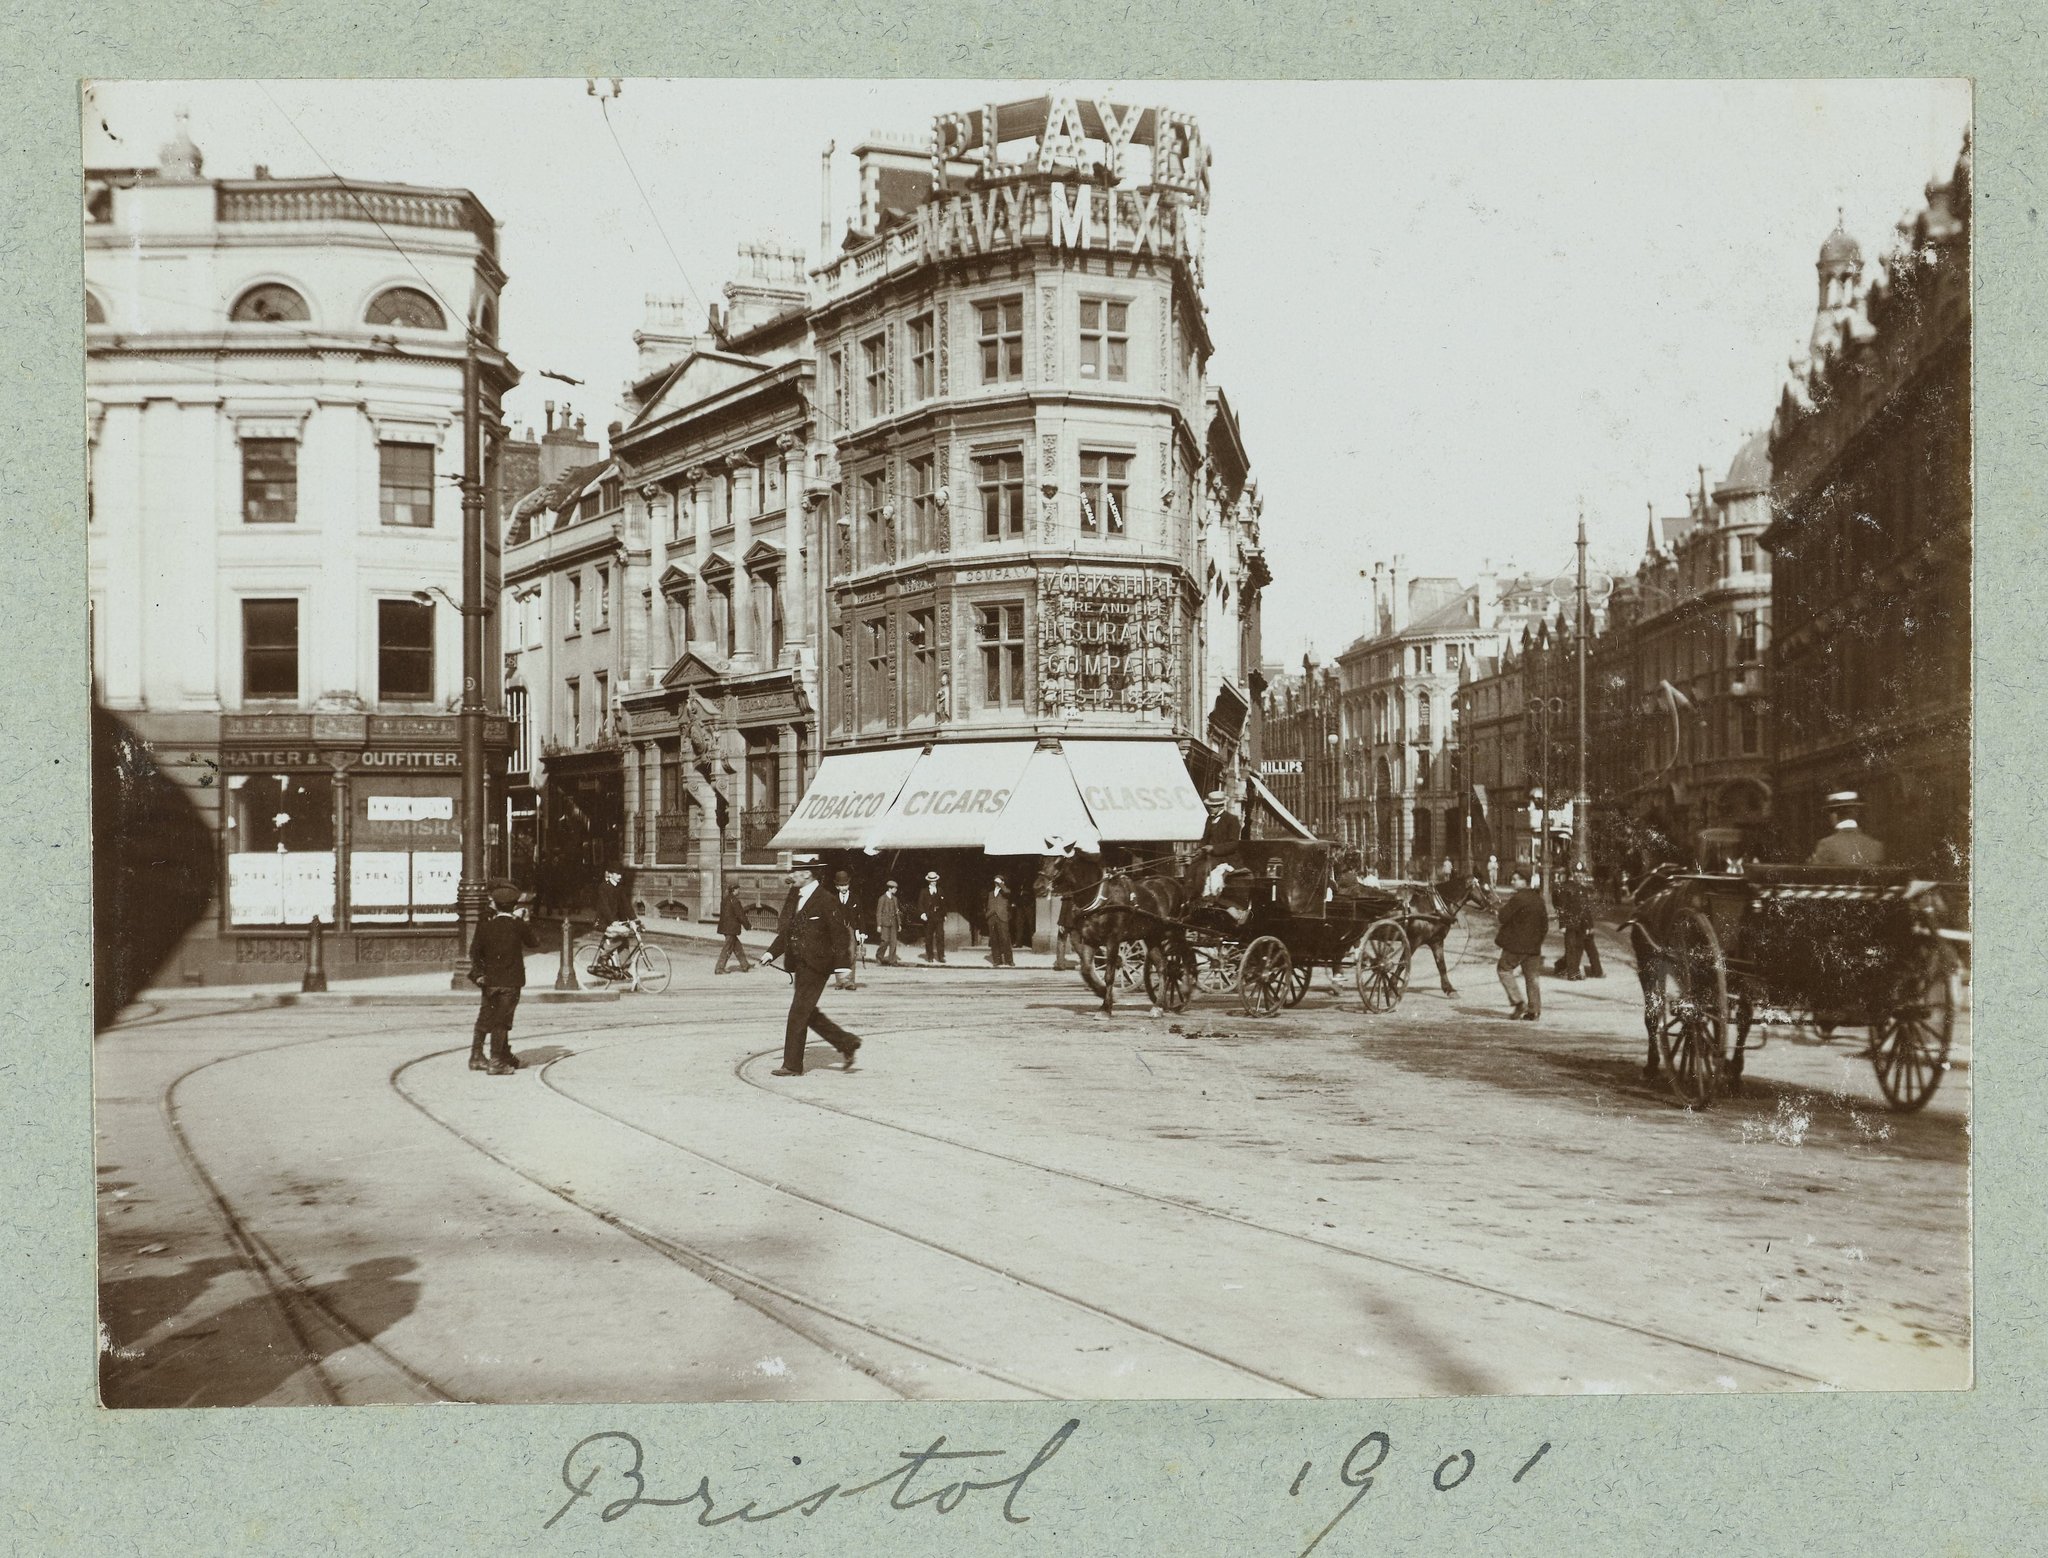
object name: photograph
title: Photographieën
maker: frits freerks fontein fz.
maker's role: fotograaf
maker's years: 1882-1928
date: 1901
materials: cardboard, paper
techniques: gelatin silver print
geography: england